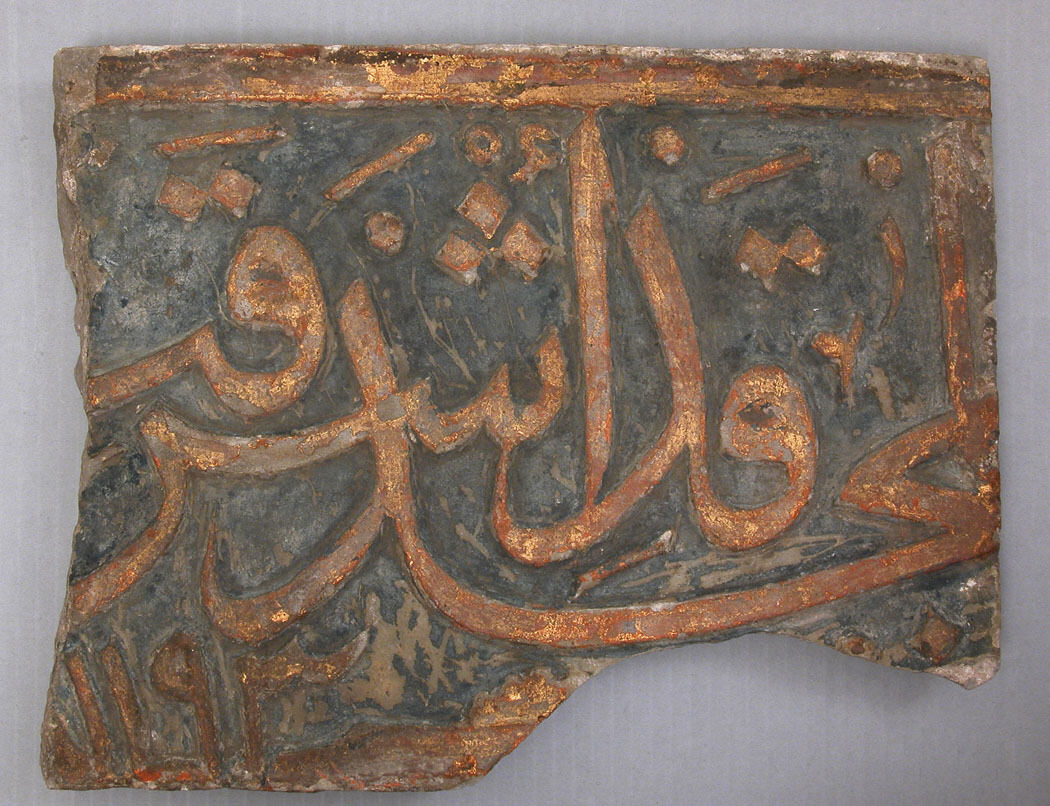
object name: frieze fragment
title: Fragment of an Inscribed Frieze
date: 1701-1800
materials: marble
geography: turkey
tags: calligraphy